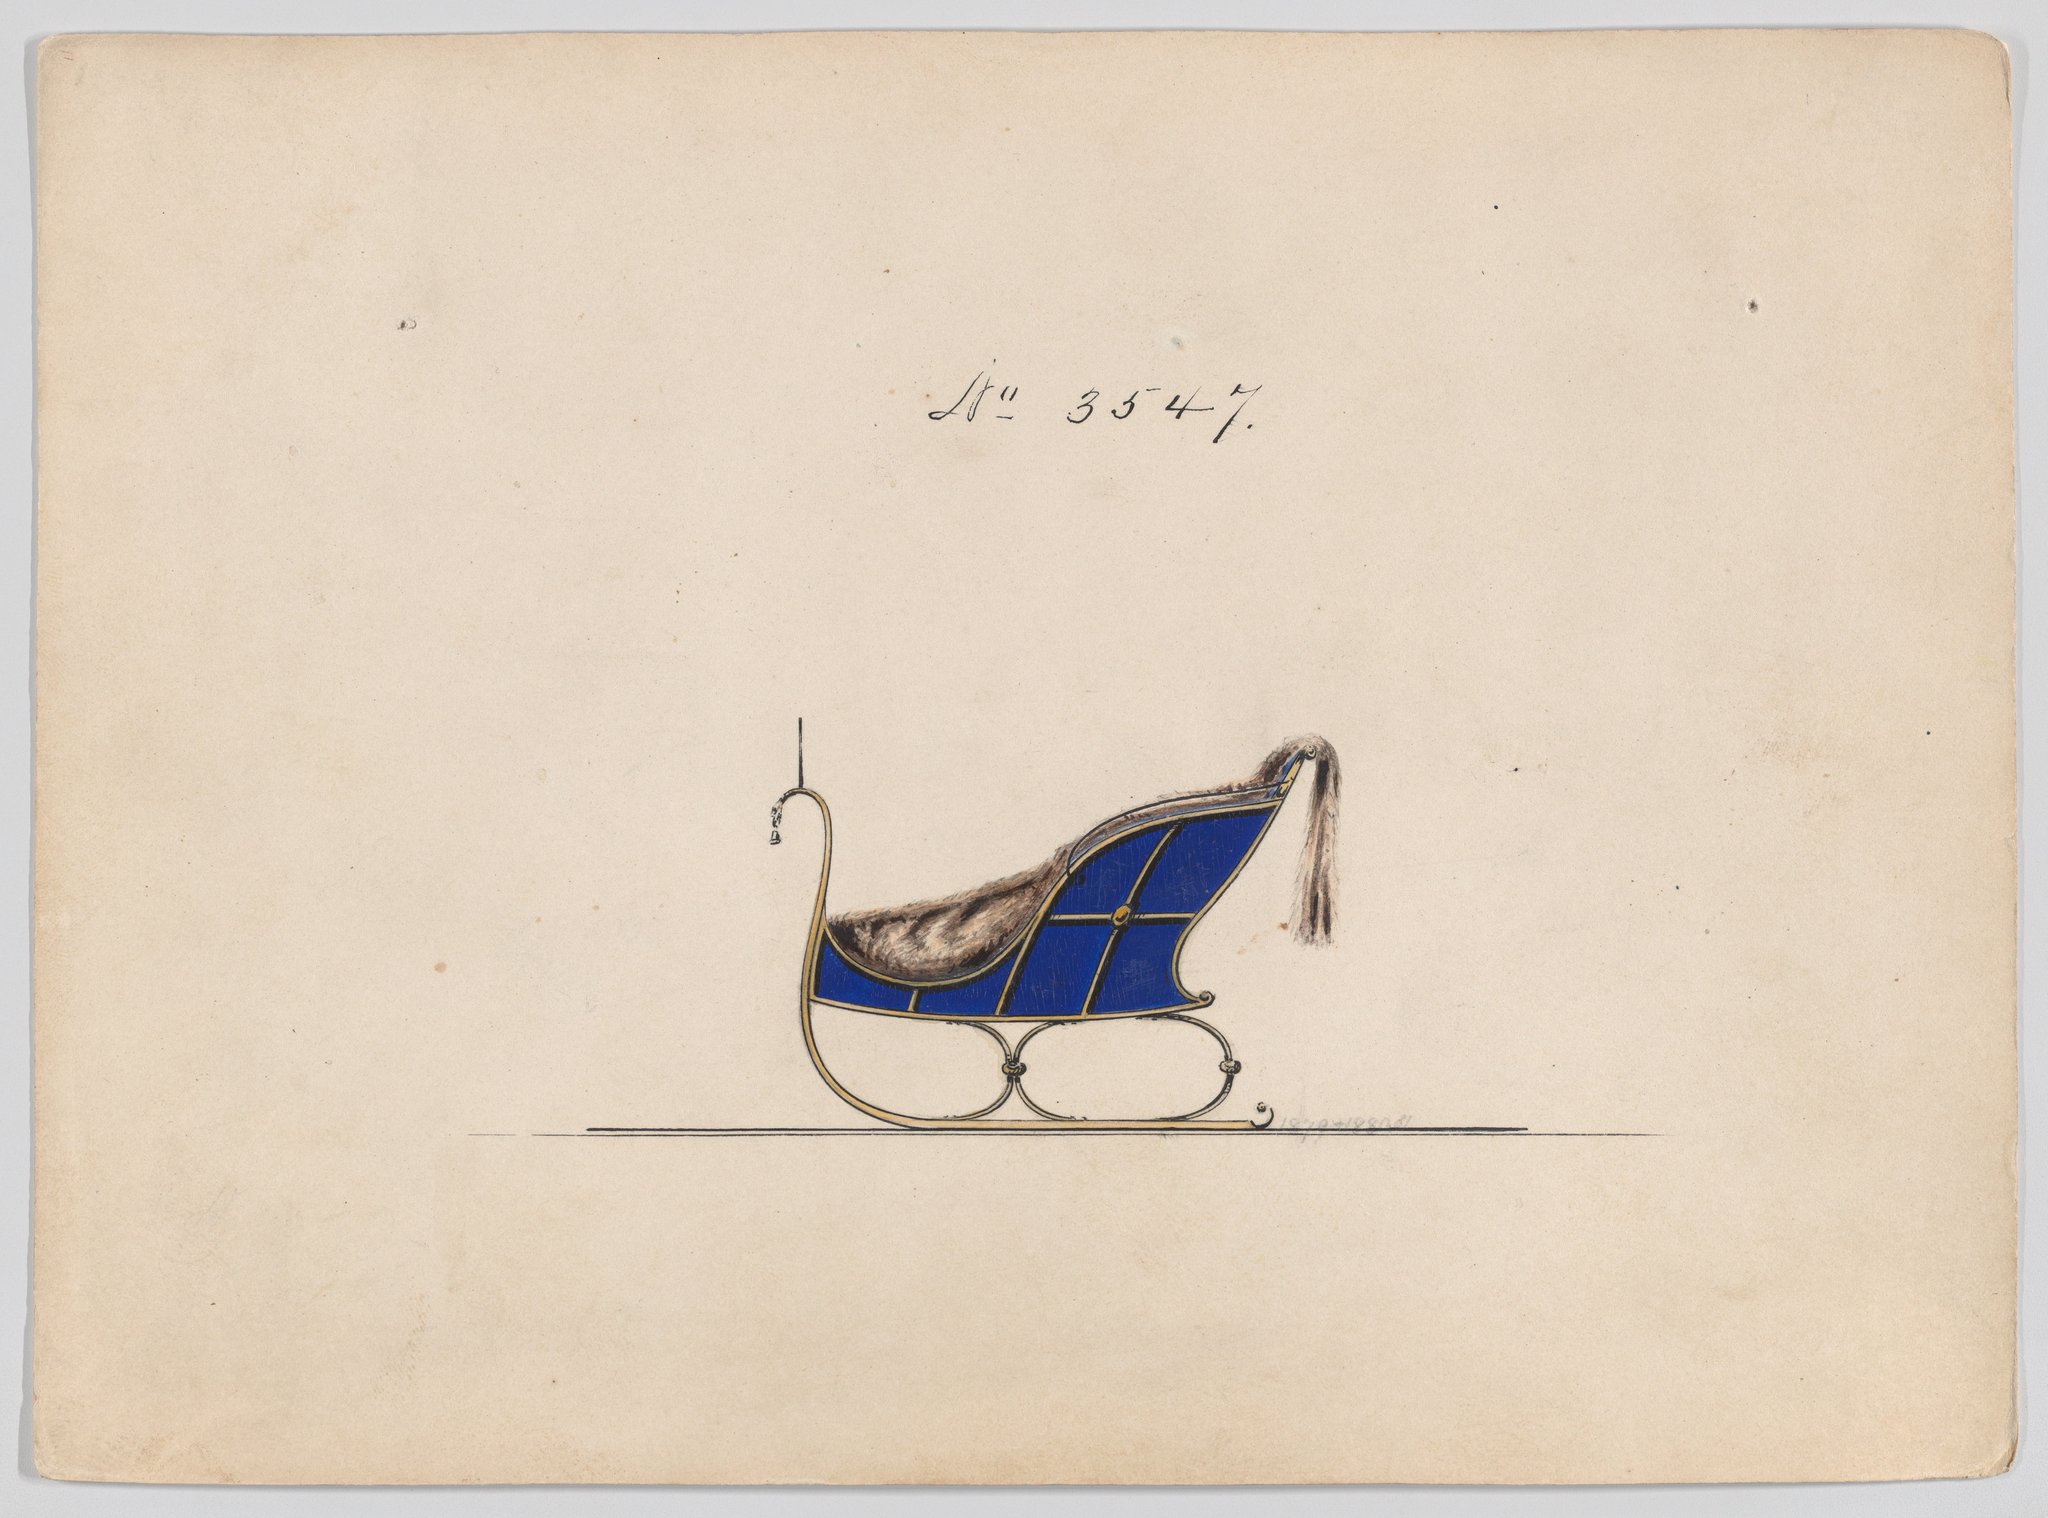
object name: drawing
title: Sleigh #3547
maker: brewster & co.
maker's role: manufacturer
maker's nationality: american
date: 1879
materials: gouache, gum arabic, ink, watercolor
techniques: pen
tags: sleighs